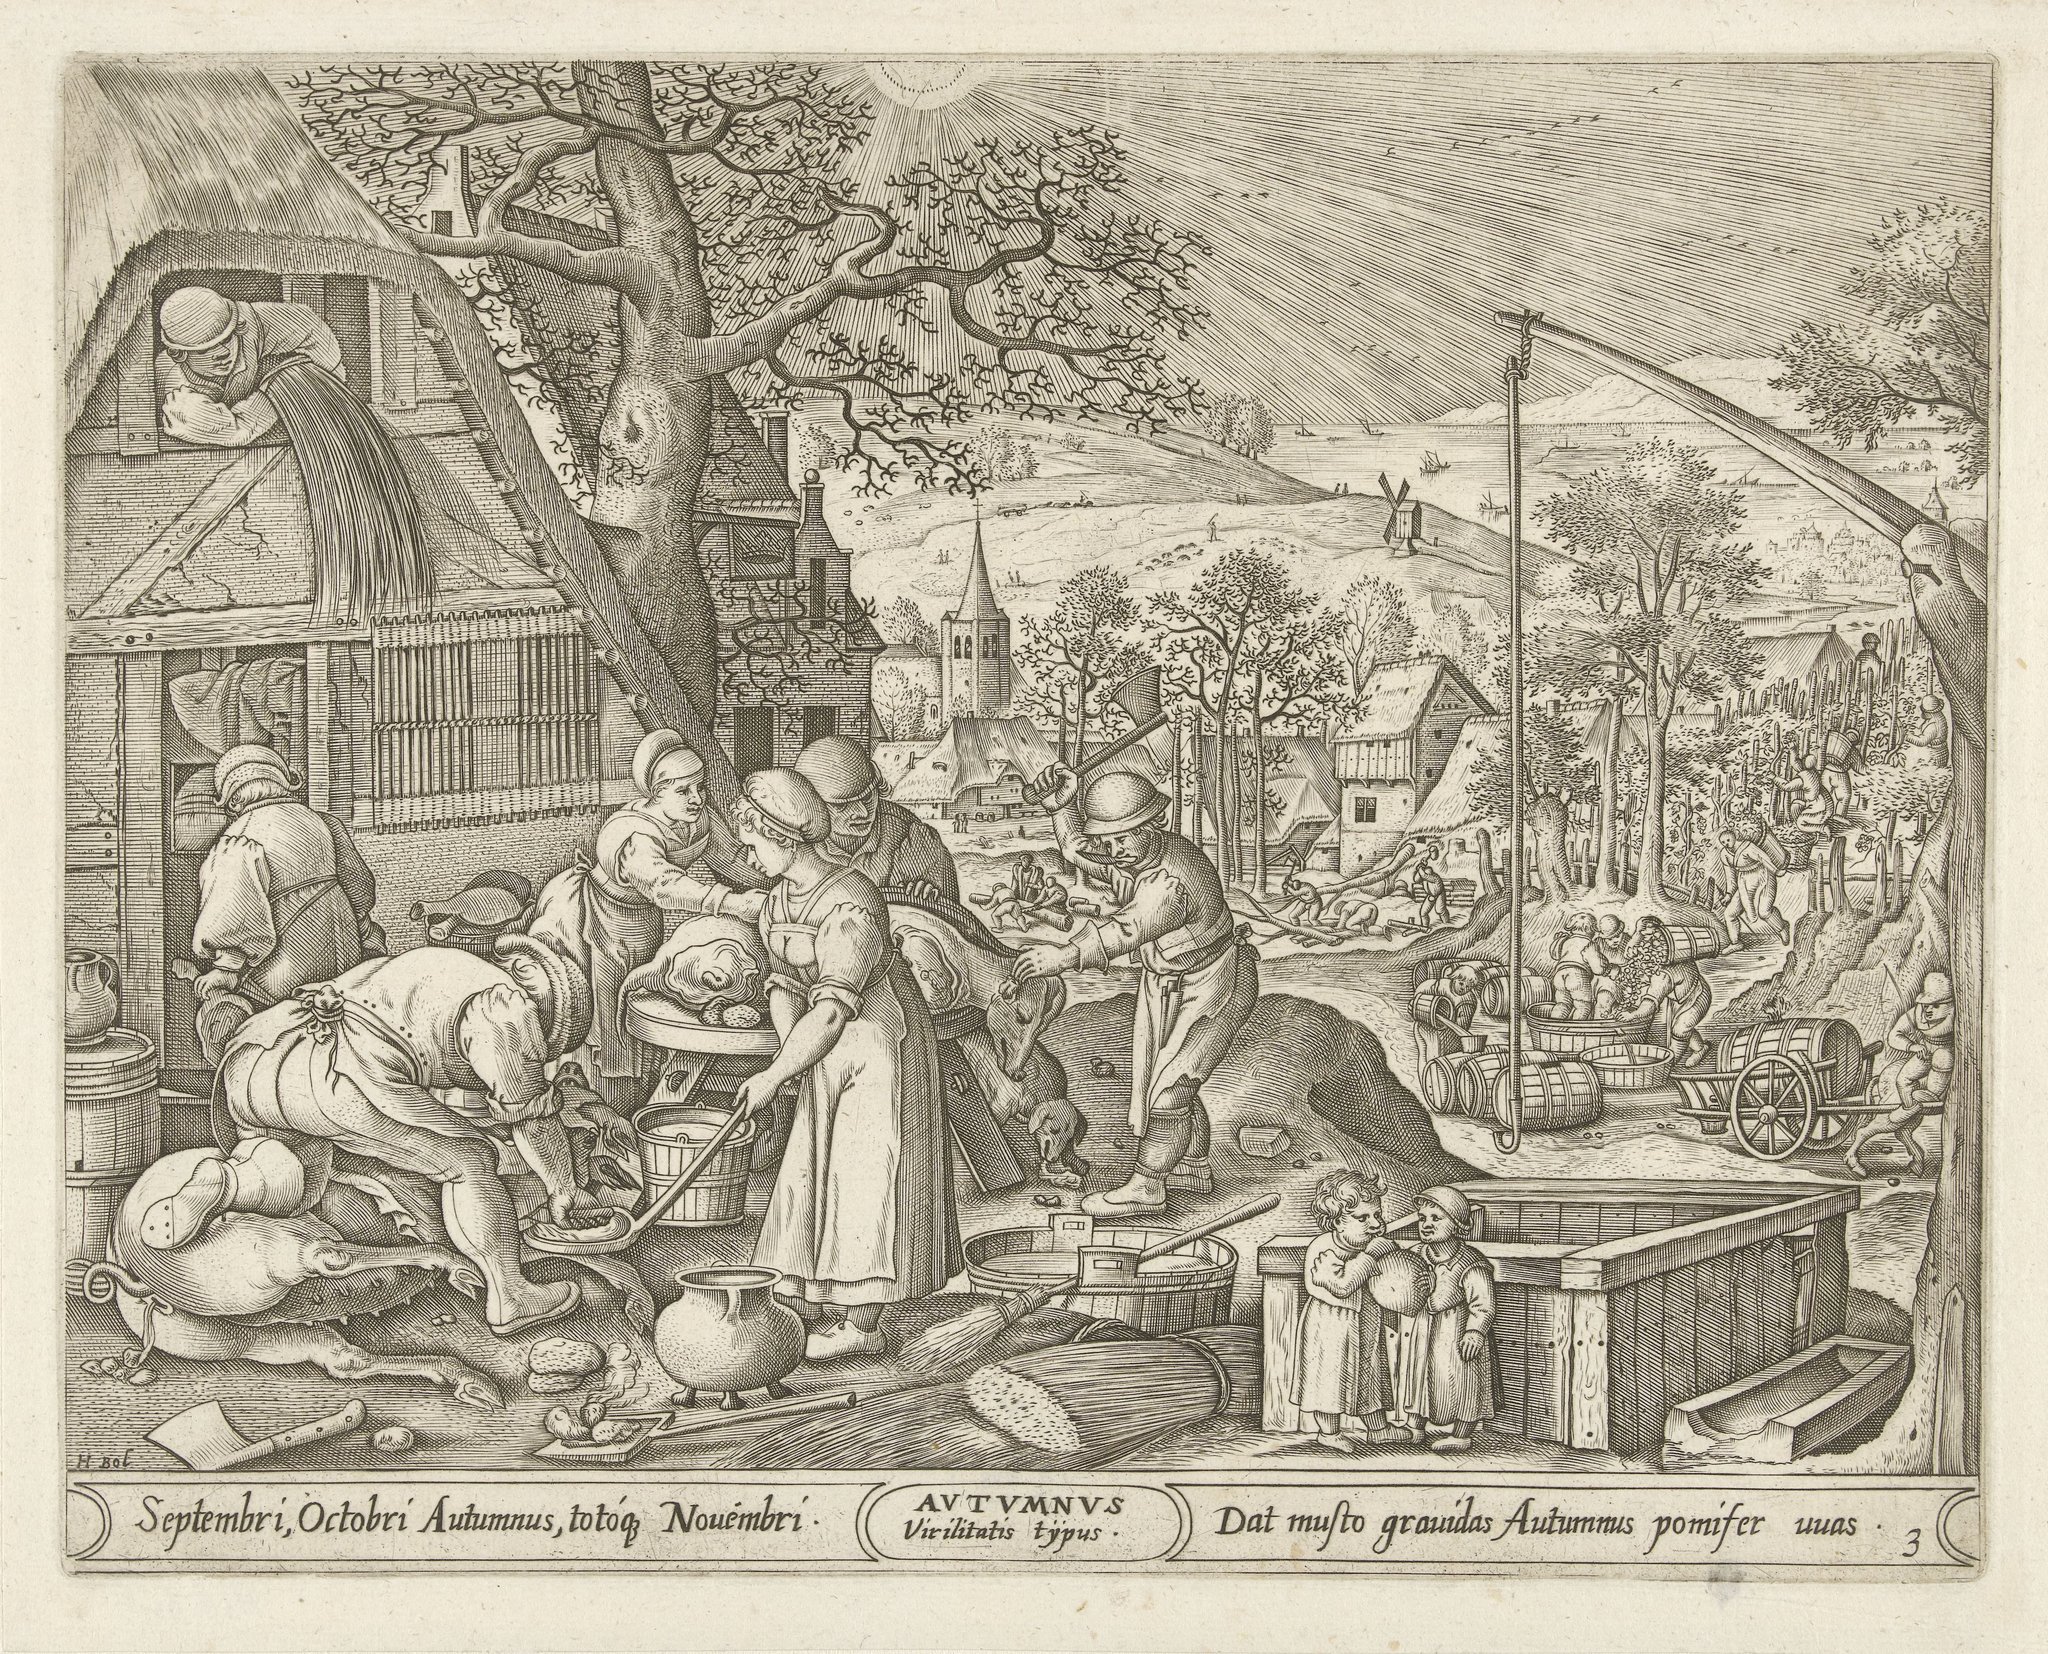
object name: print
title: Herfst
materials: paper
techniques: engraving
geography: antwerp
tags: autumn ~ human activities (the four seasons of the year), slaughtered ox or pig, autumn landscape; landscape symbolizing autumn (the four seasons of the year), the four seasons of the year ~ human activities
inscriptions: collector's mark: Lugt 2228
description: In een weids heuvellandschap verrichten dorpelingen bezigheden die horen bij de maanden september, oktober en november: Op de voorgrond wordt vee geslacht, op de achtergrond wordt geoogst en hout gehakt. Onder de voorstelling de titel met aan weerszijden daarvan twee regels in het Latijn. Prent uit een serie van vier prenten met voorstellingen van de vier seizoenen, waarvan twee naar Hans Bol en twee naar Pieter Brueghel I.